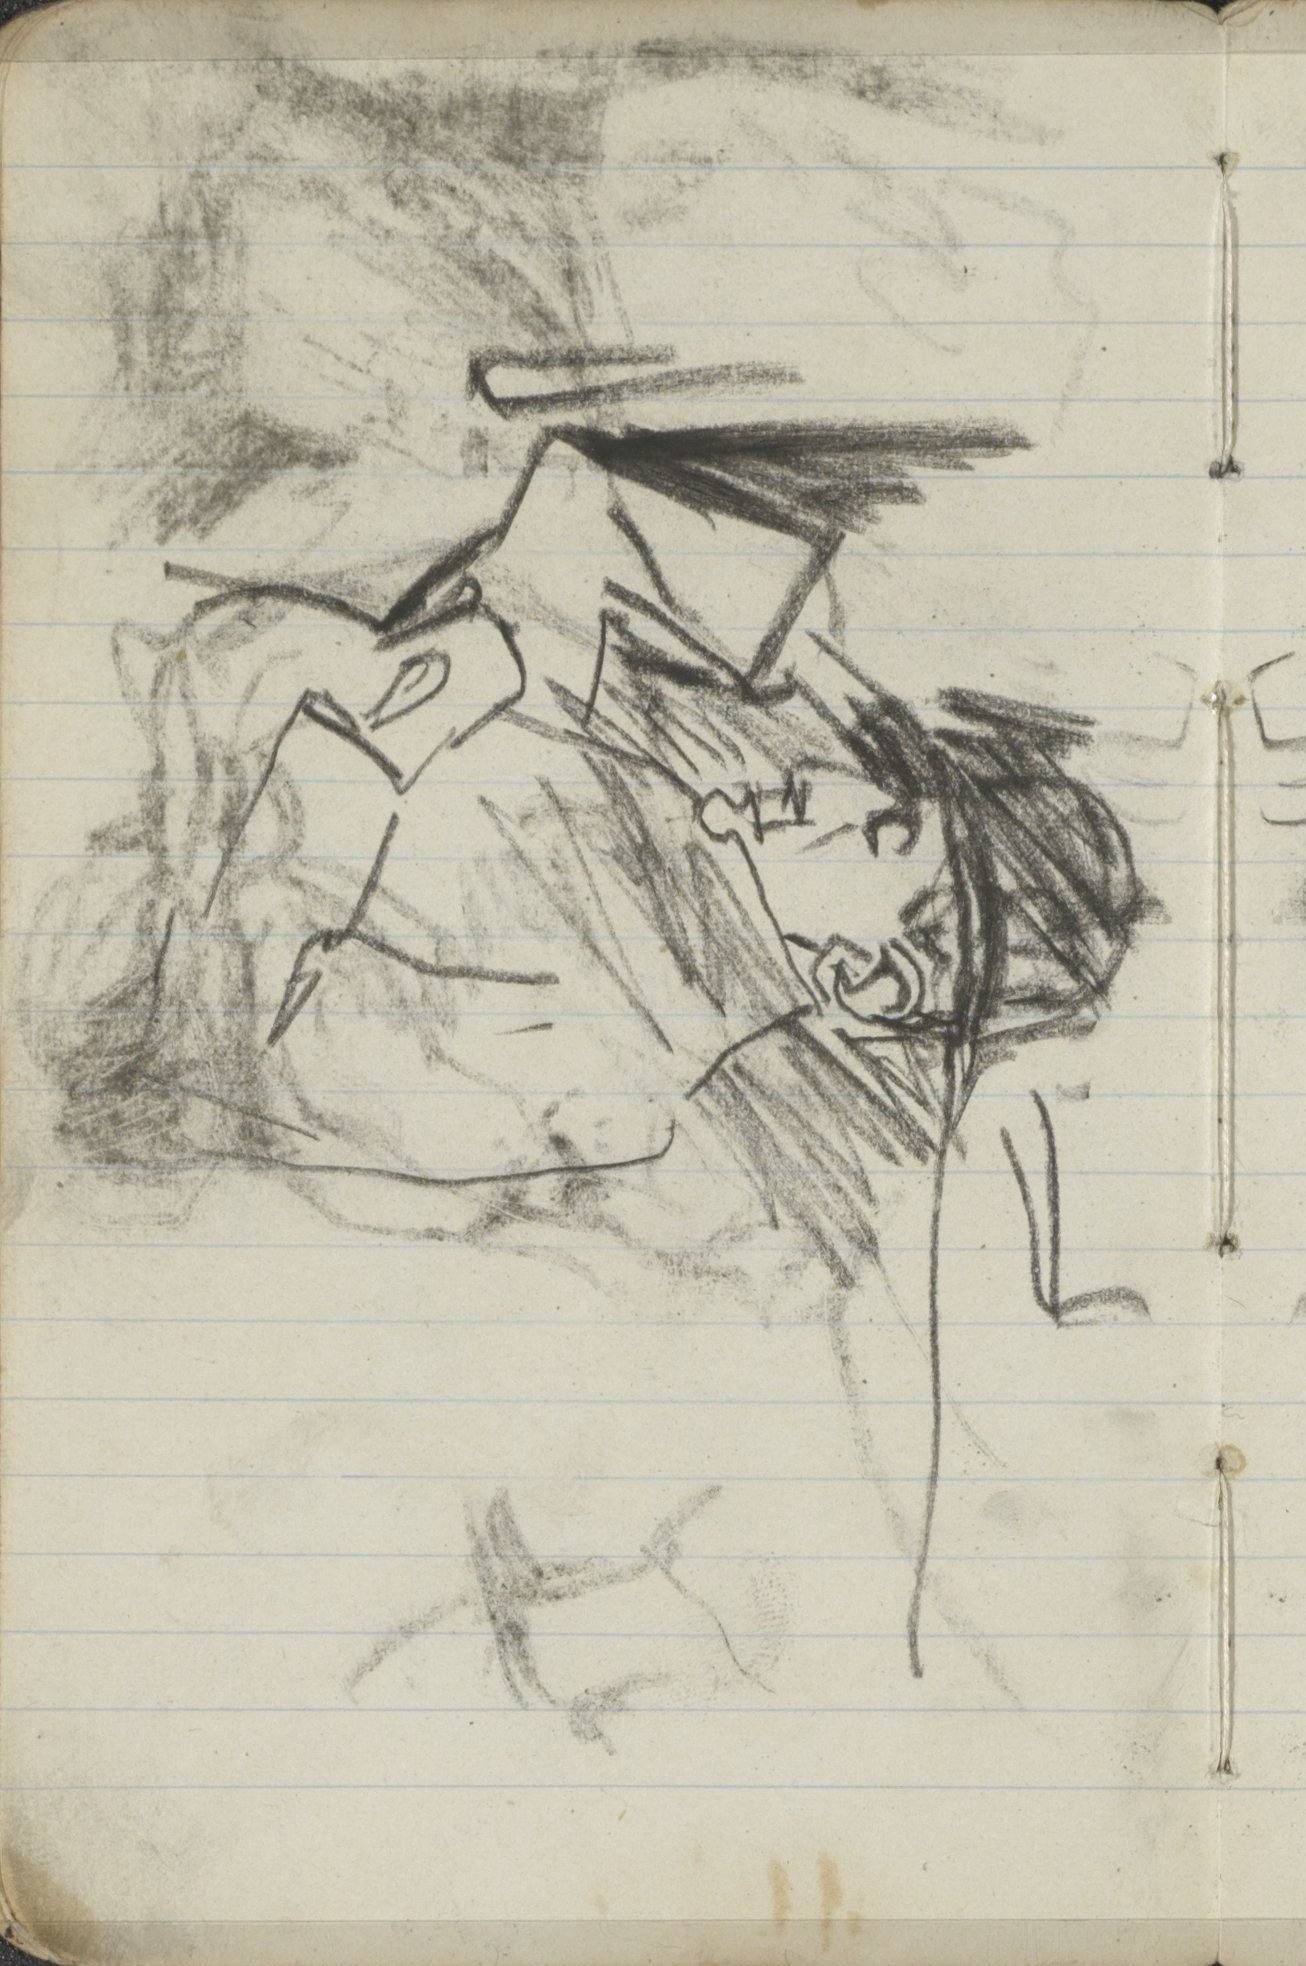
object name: sketchbook leaf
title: Man met hoed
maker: george hendrik breitner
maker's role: draughtsman, painter, print maker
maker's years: 1857-1923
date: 1894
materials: chalk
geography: amsterdam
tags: reading, adult man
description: Mogelijk lezend. Pagina 9 uit een schetsboek met 31 bladen.